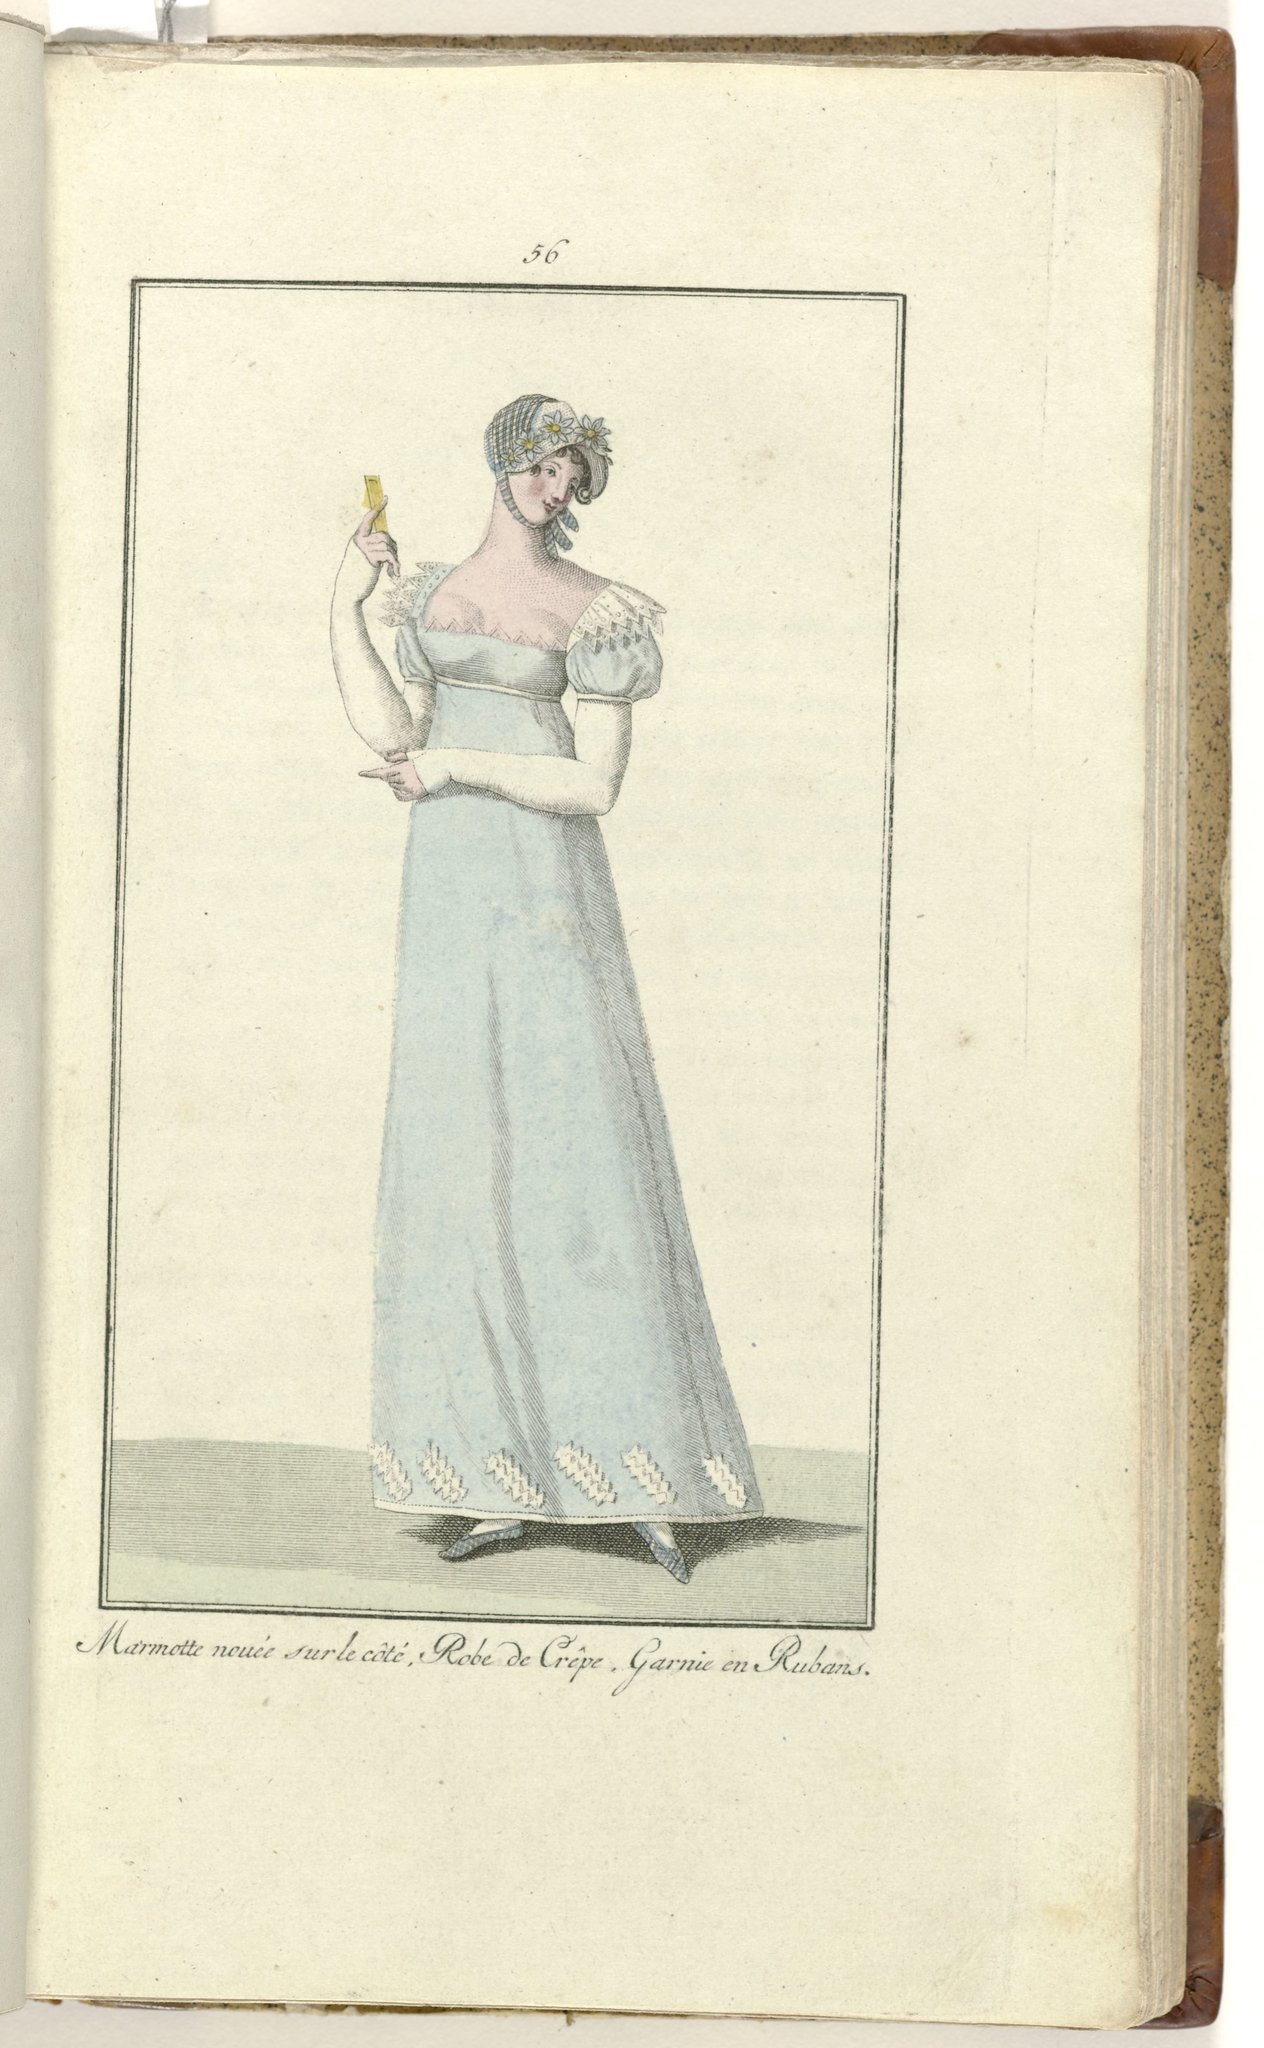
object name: magazine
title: Elegantia, of tijdschrift van mode, luxe en smaak voor dames, September 1808, No. 56: Marmotte nouée sur le côté...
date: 1808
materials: paper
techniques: engraving, hand coloring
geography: amsterdam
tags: border, ribbon, braid (+ women's clothes), gloves, mittens (mitaines) (+ women's clothes), fashion plates, head-gear: hat (+ women's clothes), shoes, sandals (+ women's clothes), dress, gown (+ women's clothes), fan (+ women's clothes)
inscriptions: caption: ‘Marmotte nouée sur le côté, Robe de Crêpe, Garnie en Rubans.’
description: Volgens de begeleidende tekst (p. 288): Japon van blauwe crêpe gegarneerd met witte linten. 'Casaque' van wit stro met een zijden 'marmotte' die aan de zijkant is vastgeknoopt. Witte mitaines. Prent uit het modetijdschrift Elegantia, of tijdschrift van mode, luxe en smaak voor dames 1807-1814 (onderbroken door de periode 1811-1813).